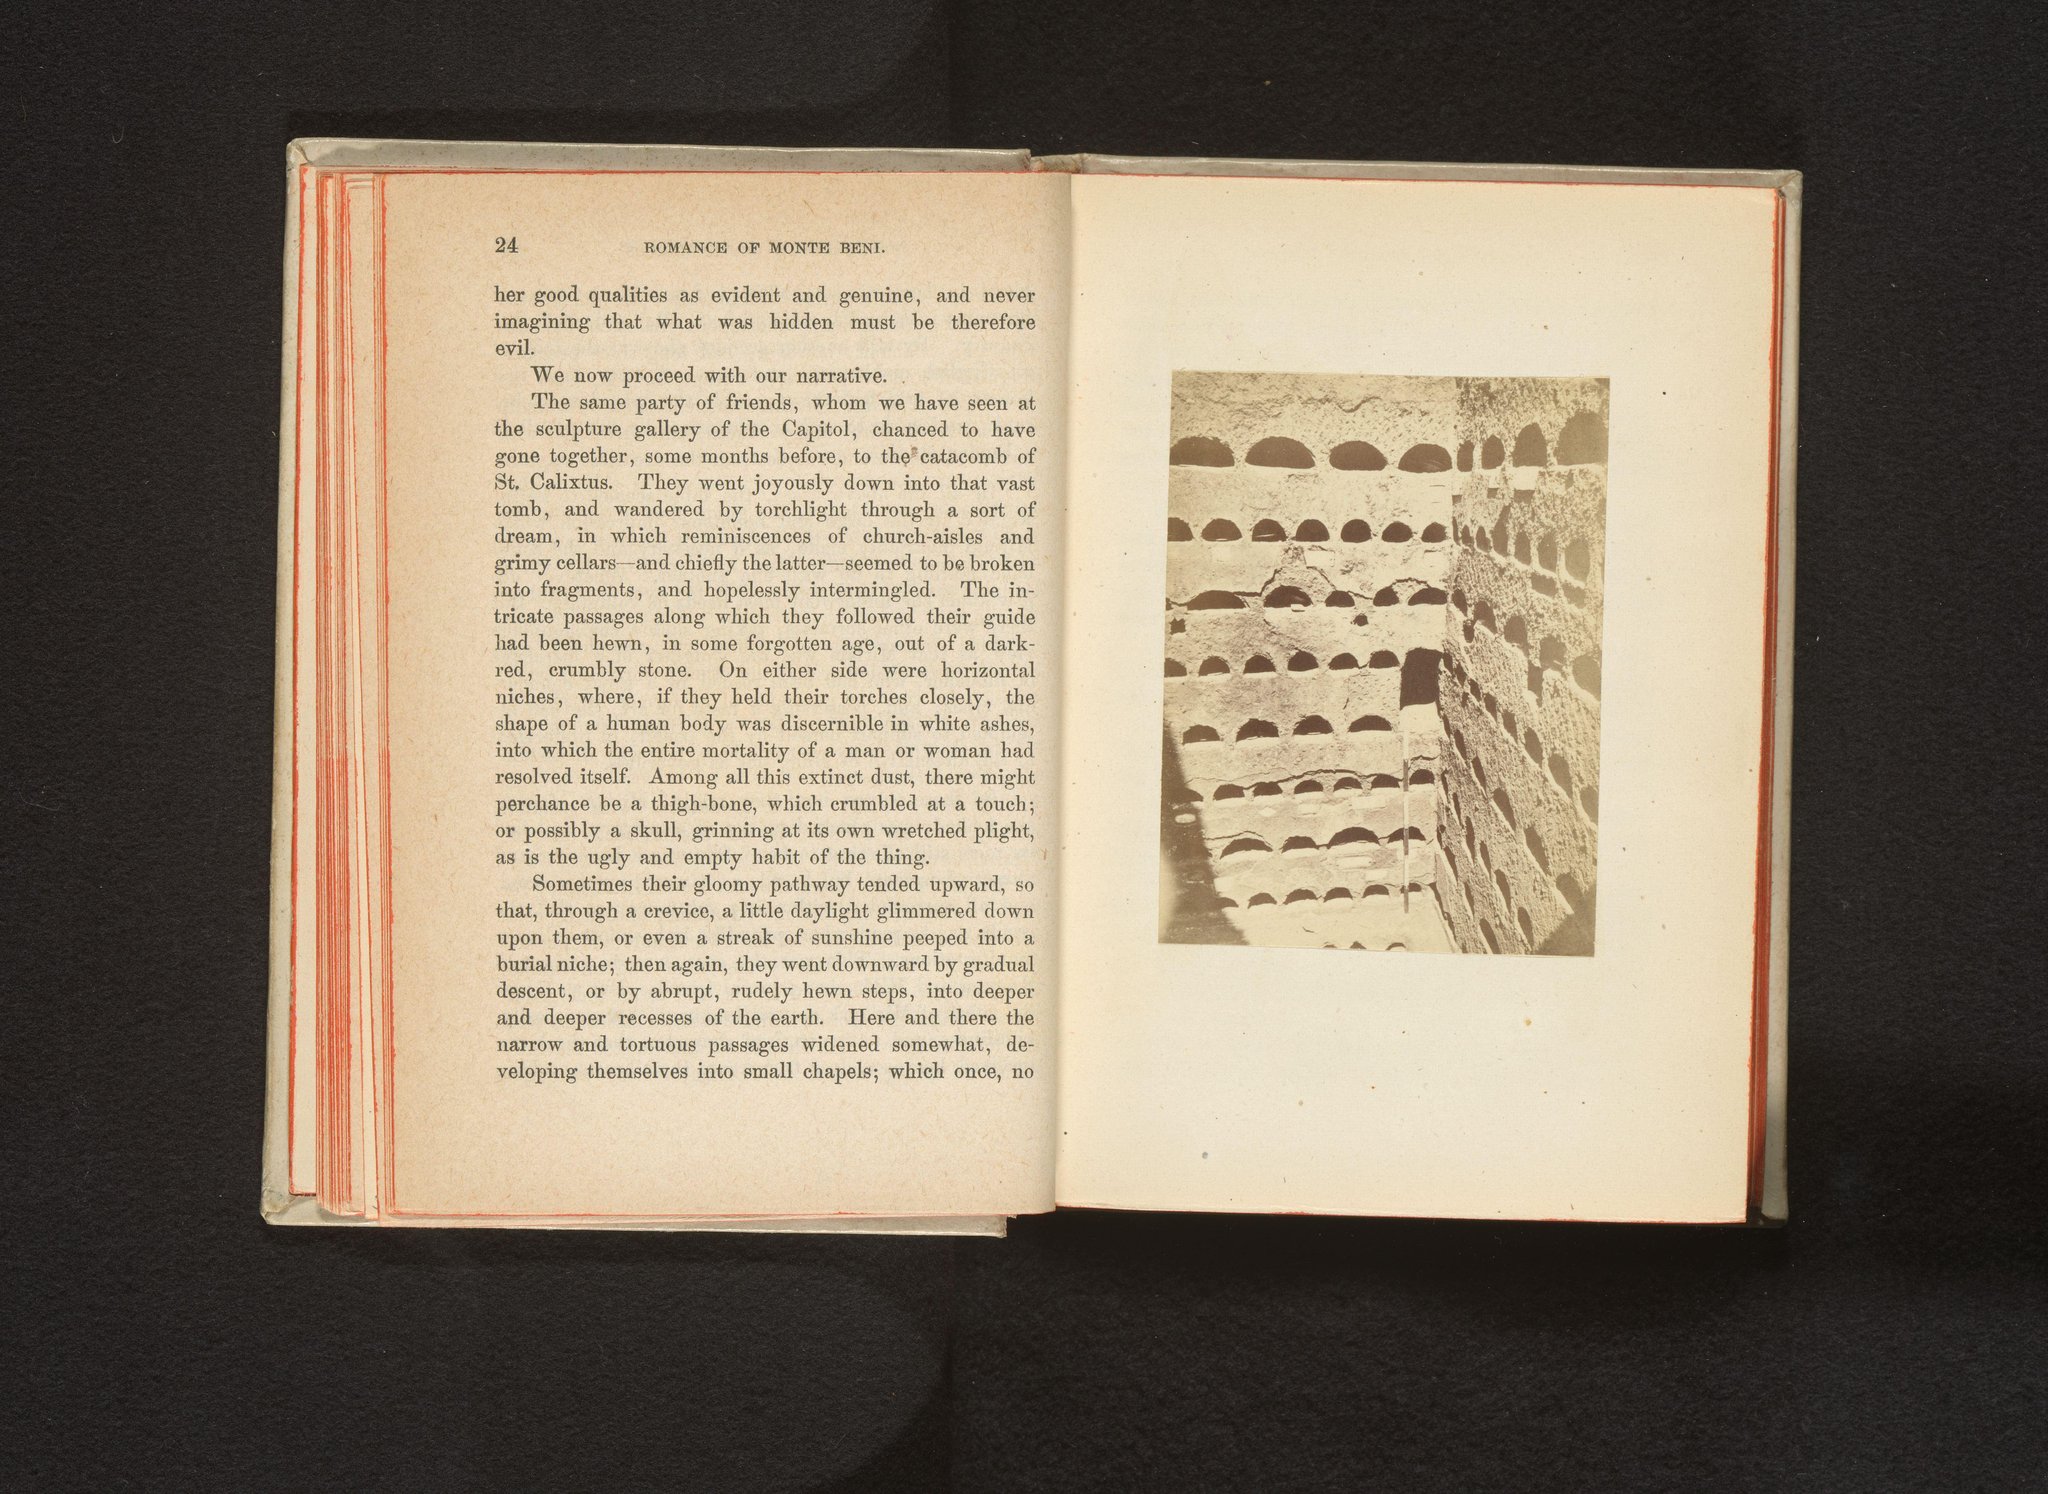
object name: photograph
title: Graven in de muur, vermoedelijk in de catacomben van Sint-Calixtus in Rome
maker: Anonymous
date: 1850-1860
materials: photographic support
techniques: albumen print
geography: rome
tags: ancient grave forms, rome